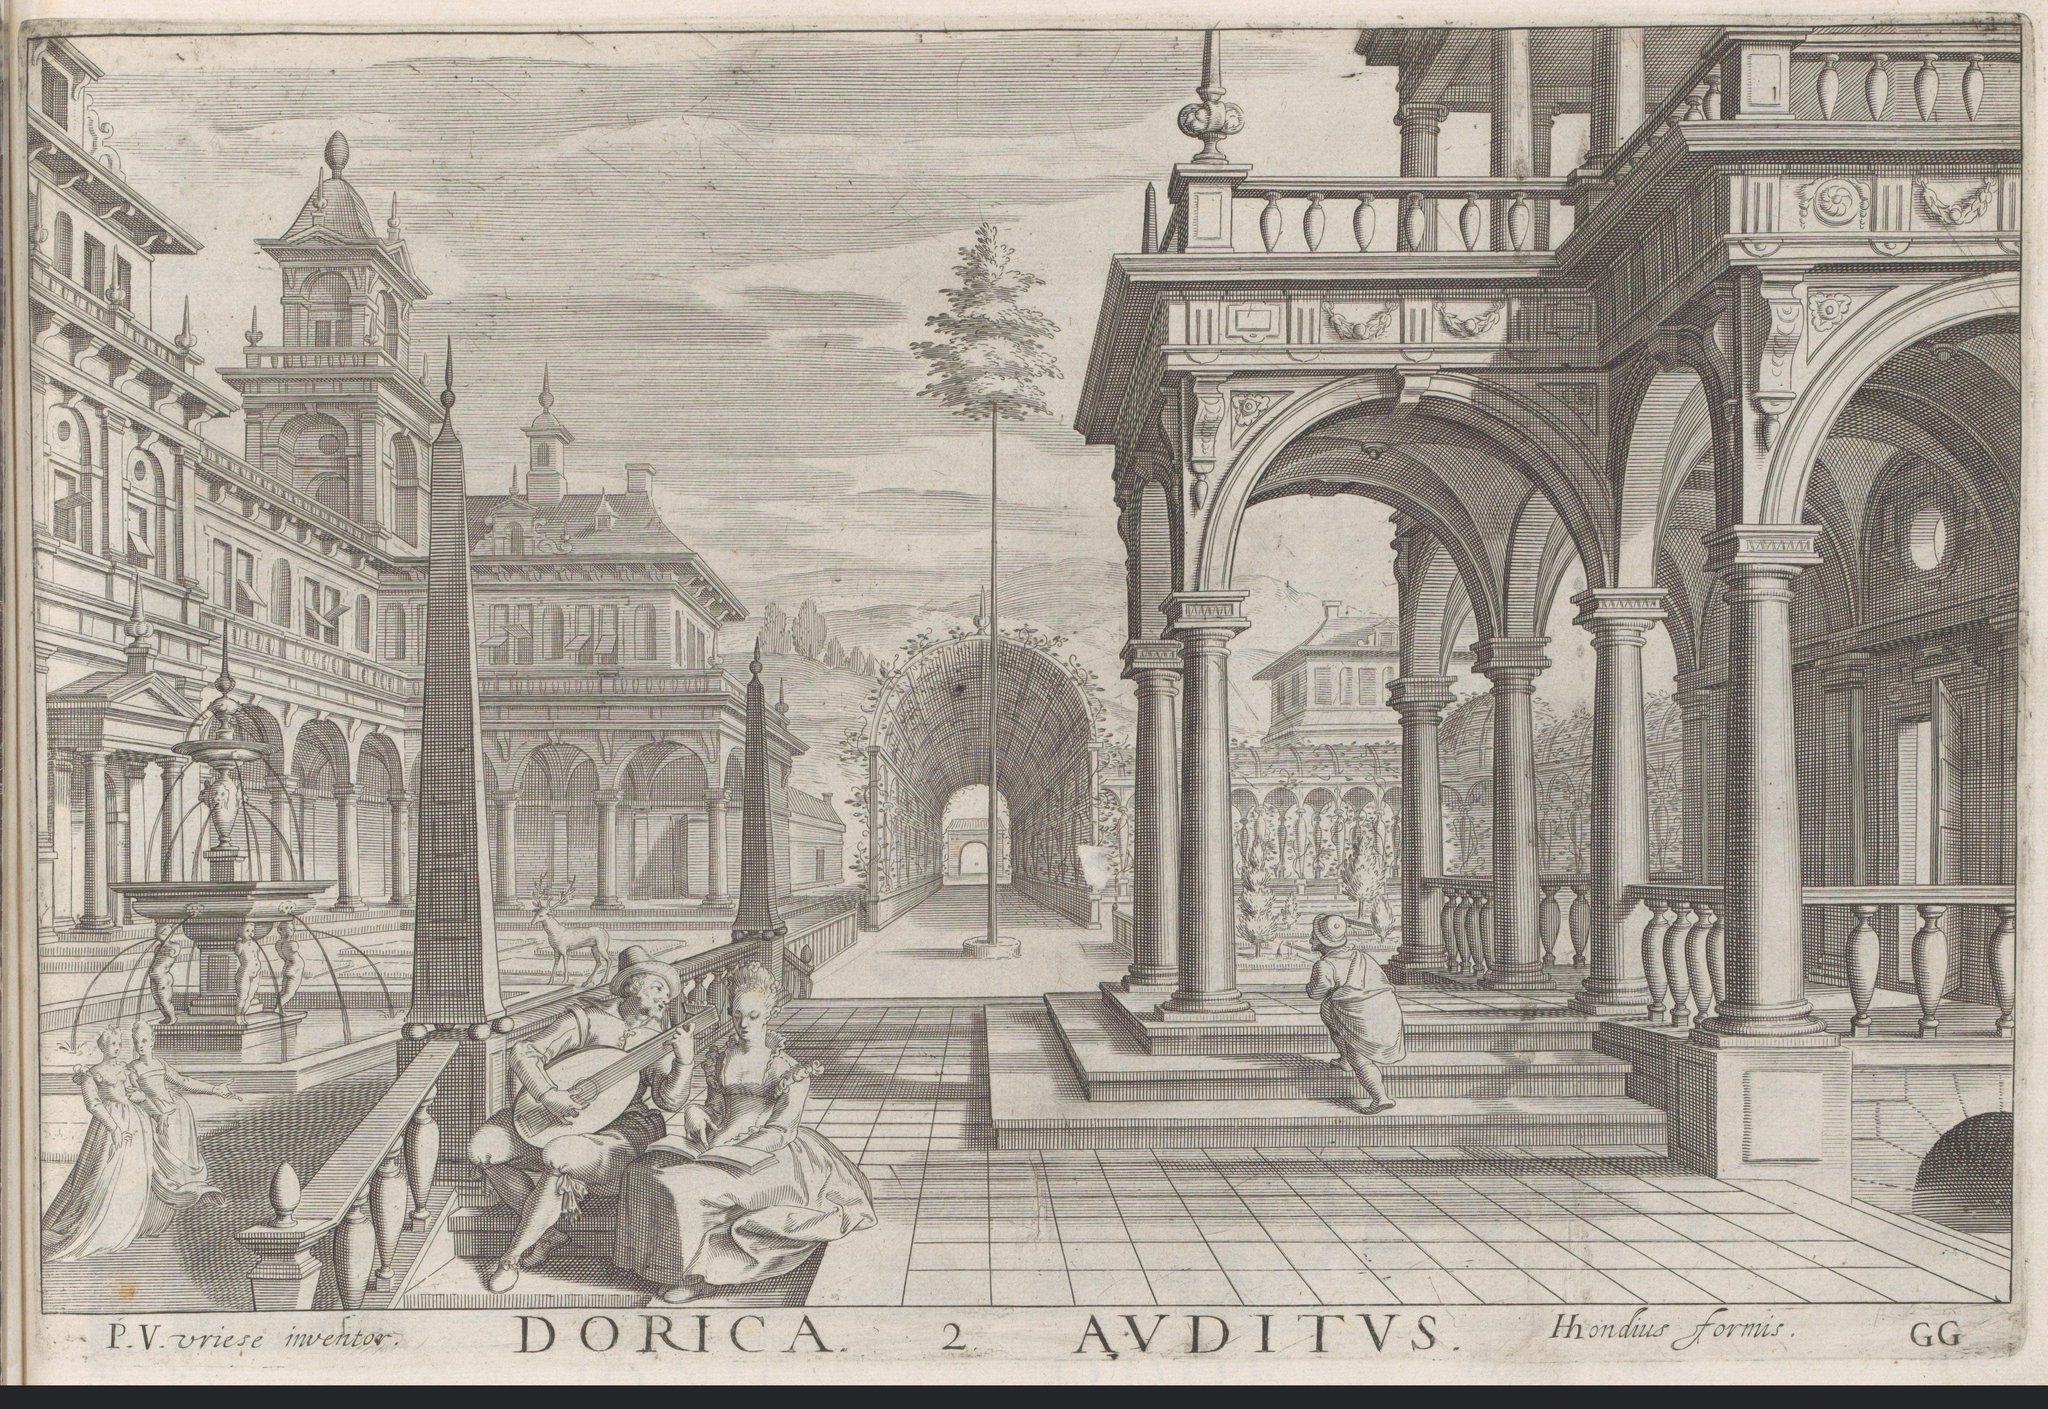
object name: album leaf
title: De vijf zintuigen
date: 1606-1607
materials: paper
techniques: engraving, etching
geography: amsterdam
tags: hearing, listening (one of the five senses), doric order ~ architecture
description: Terras van een gebouw met Dorische zuilen. Op de voorgrond een man die een snaarinstrument bespeelt voor een vrouw. Zij verbeelden het zintuig gehoor. Rechtsonder: GG. Prent maakt deel uit van een album.